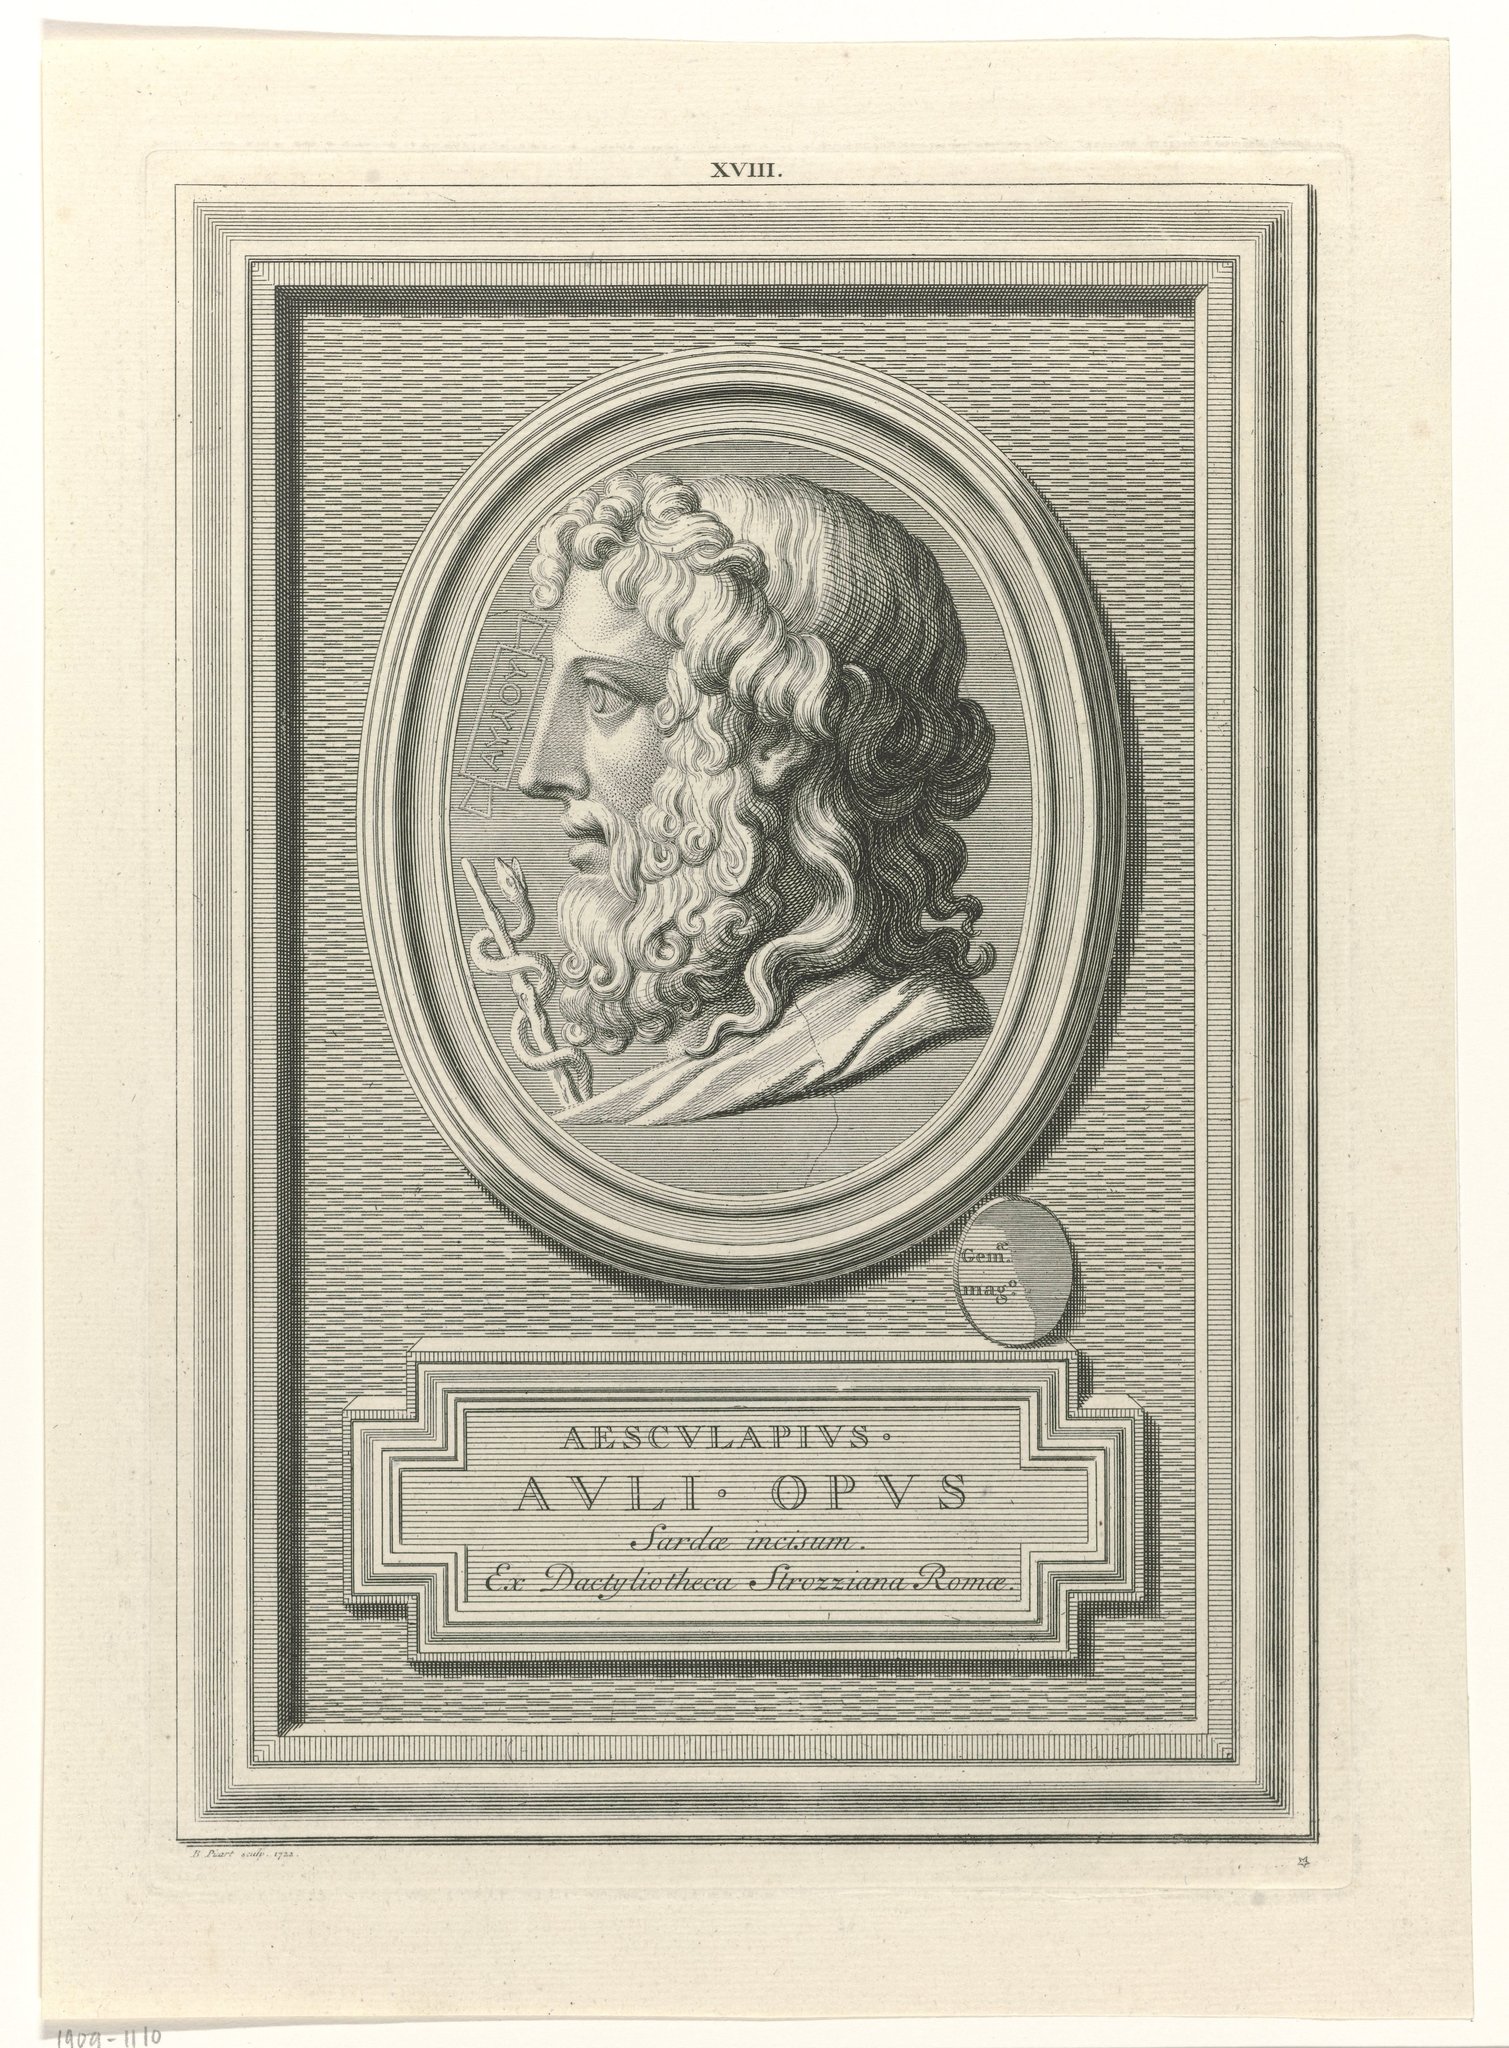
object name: print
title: Gesneden steen met de beeltenis van Aesculapius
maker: bernard picart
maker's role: draughtsman, print maker, publisher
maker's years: 1673-1733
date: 1722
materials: paper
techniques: engraving, etching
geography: amsterdam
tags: gem, gemstone (+ relief ~ sculpture), (story of) aesculapius (asclepius)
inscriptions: collector's mark: Lugt 2228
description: Het portret van Aesculapius en profil. Reproductie van een Griekse gesneden edelsteen. Rechtsonder de ware grootte van de steen. Midden boven genummerd: XVIII. Prent is afkomstig uit een boek over gesneden edelstenen en glyptiek.